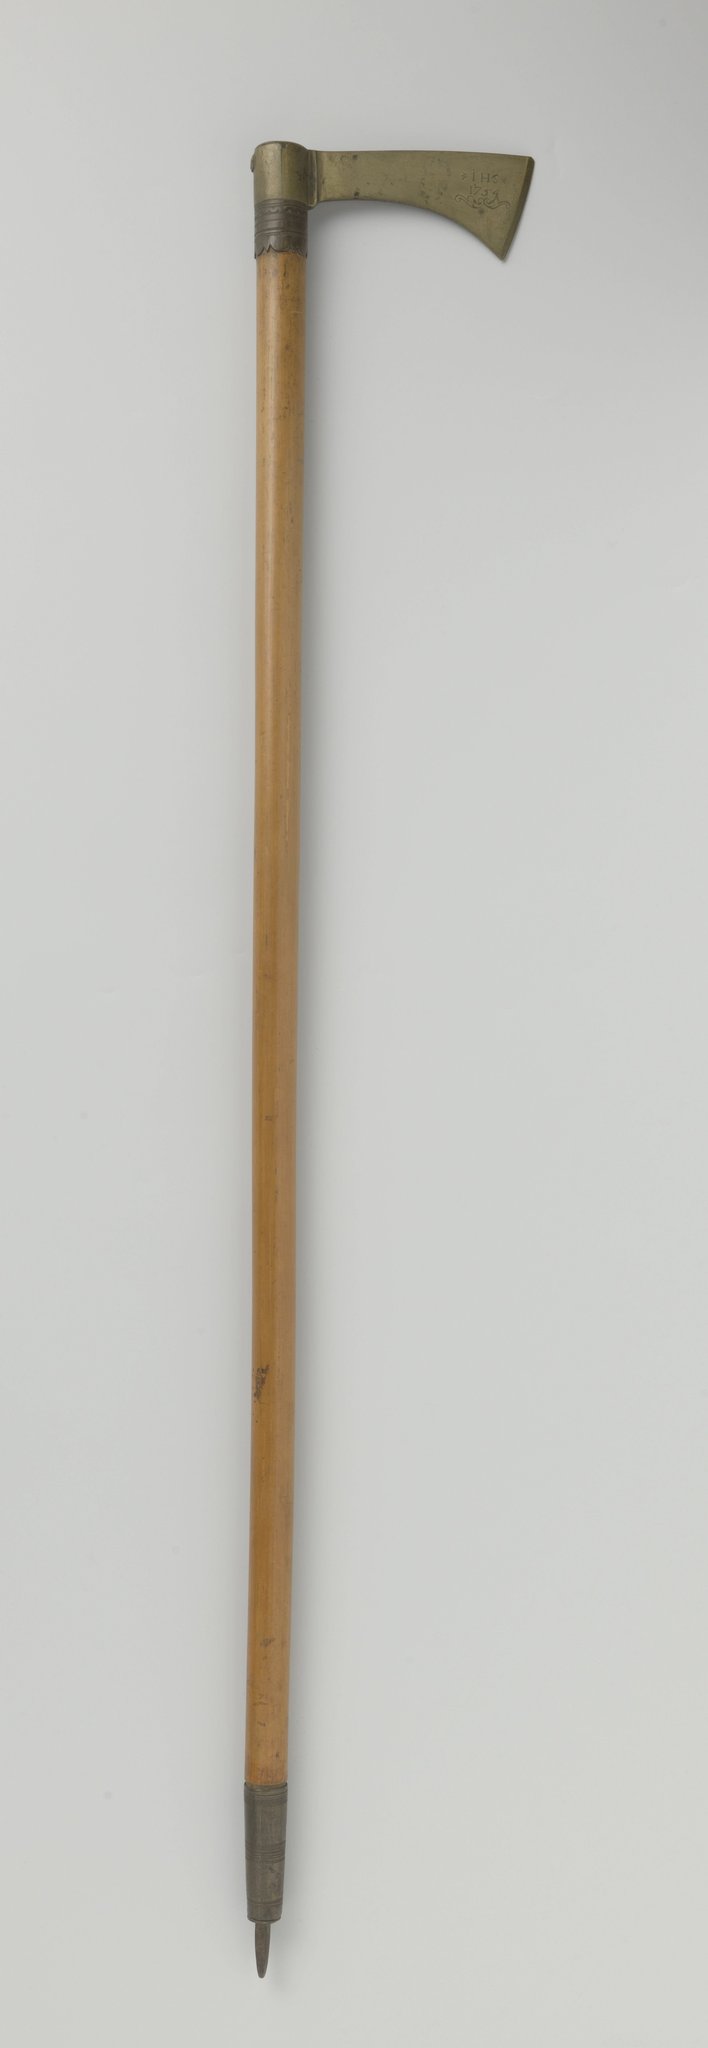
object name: gildestaf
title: Bergwerkersstok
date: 1754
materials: bamboo, copper, iron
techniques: engraving, forging, striking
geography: europe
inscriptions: date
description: Bamboestok met aan het einde een koperen bijltje met opschrift, aan het andere eind gevat in een breed ijzeren beslag en met een pin aan de andere kant. Opschrift: IHS. Gedateerd: 1754.